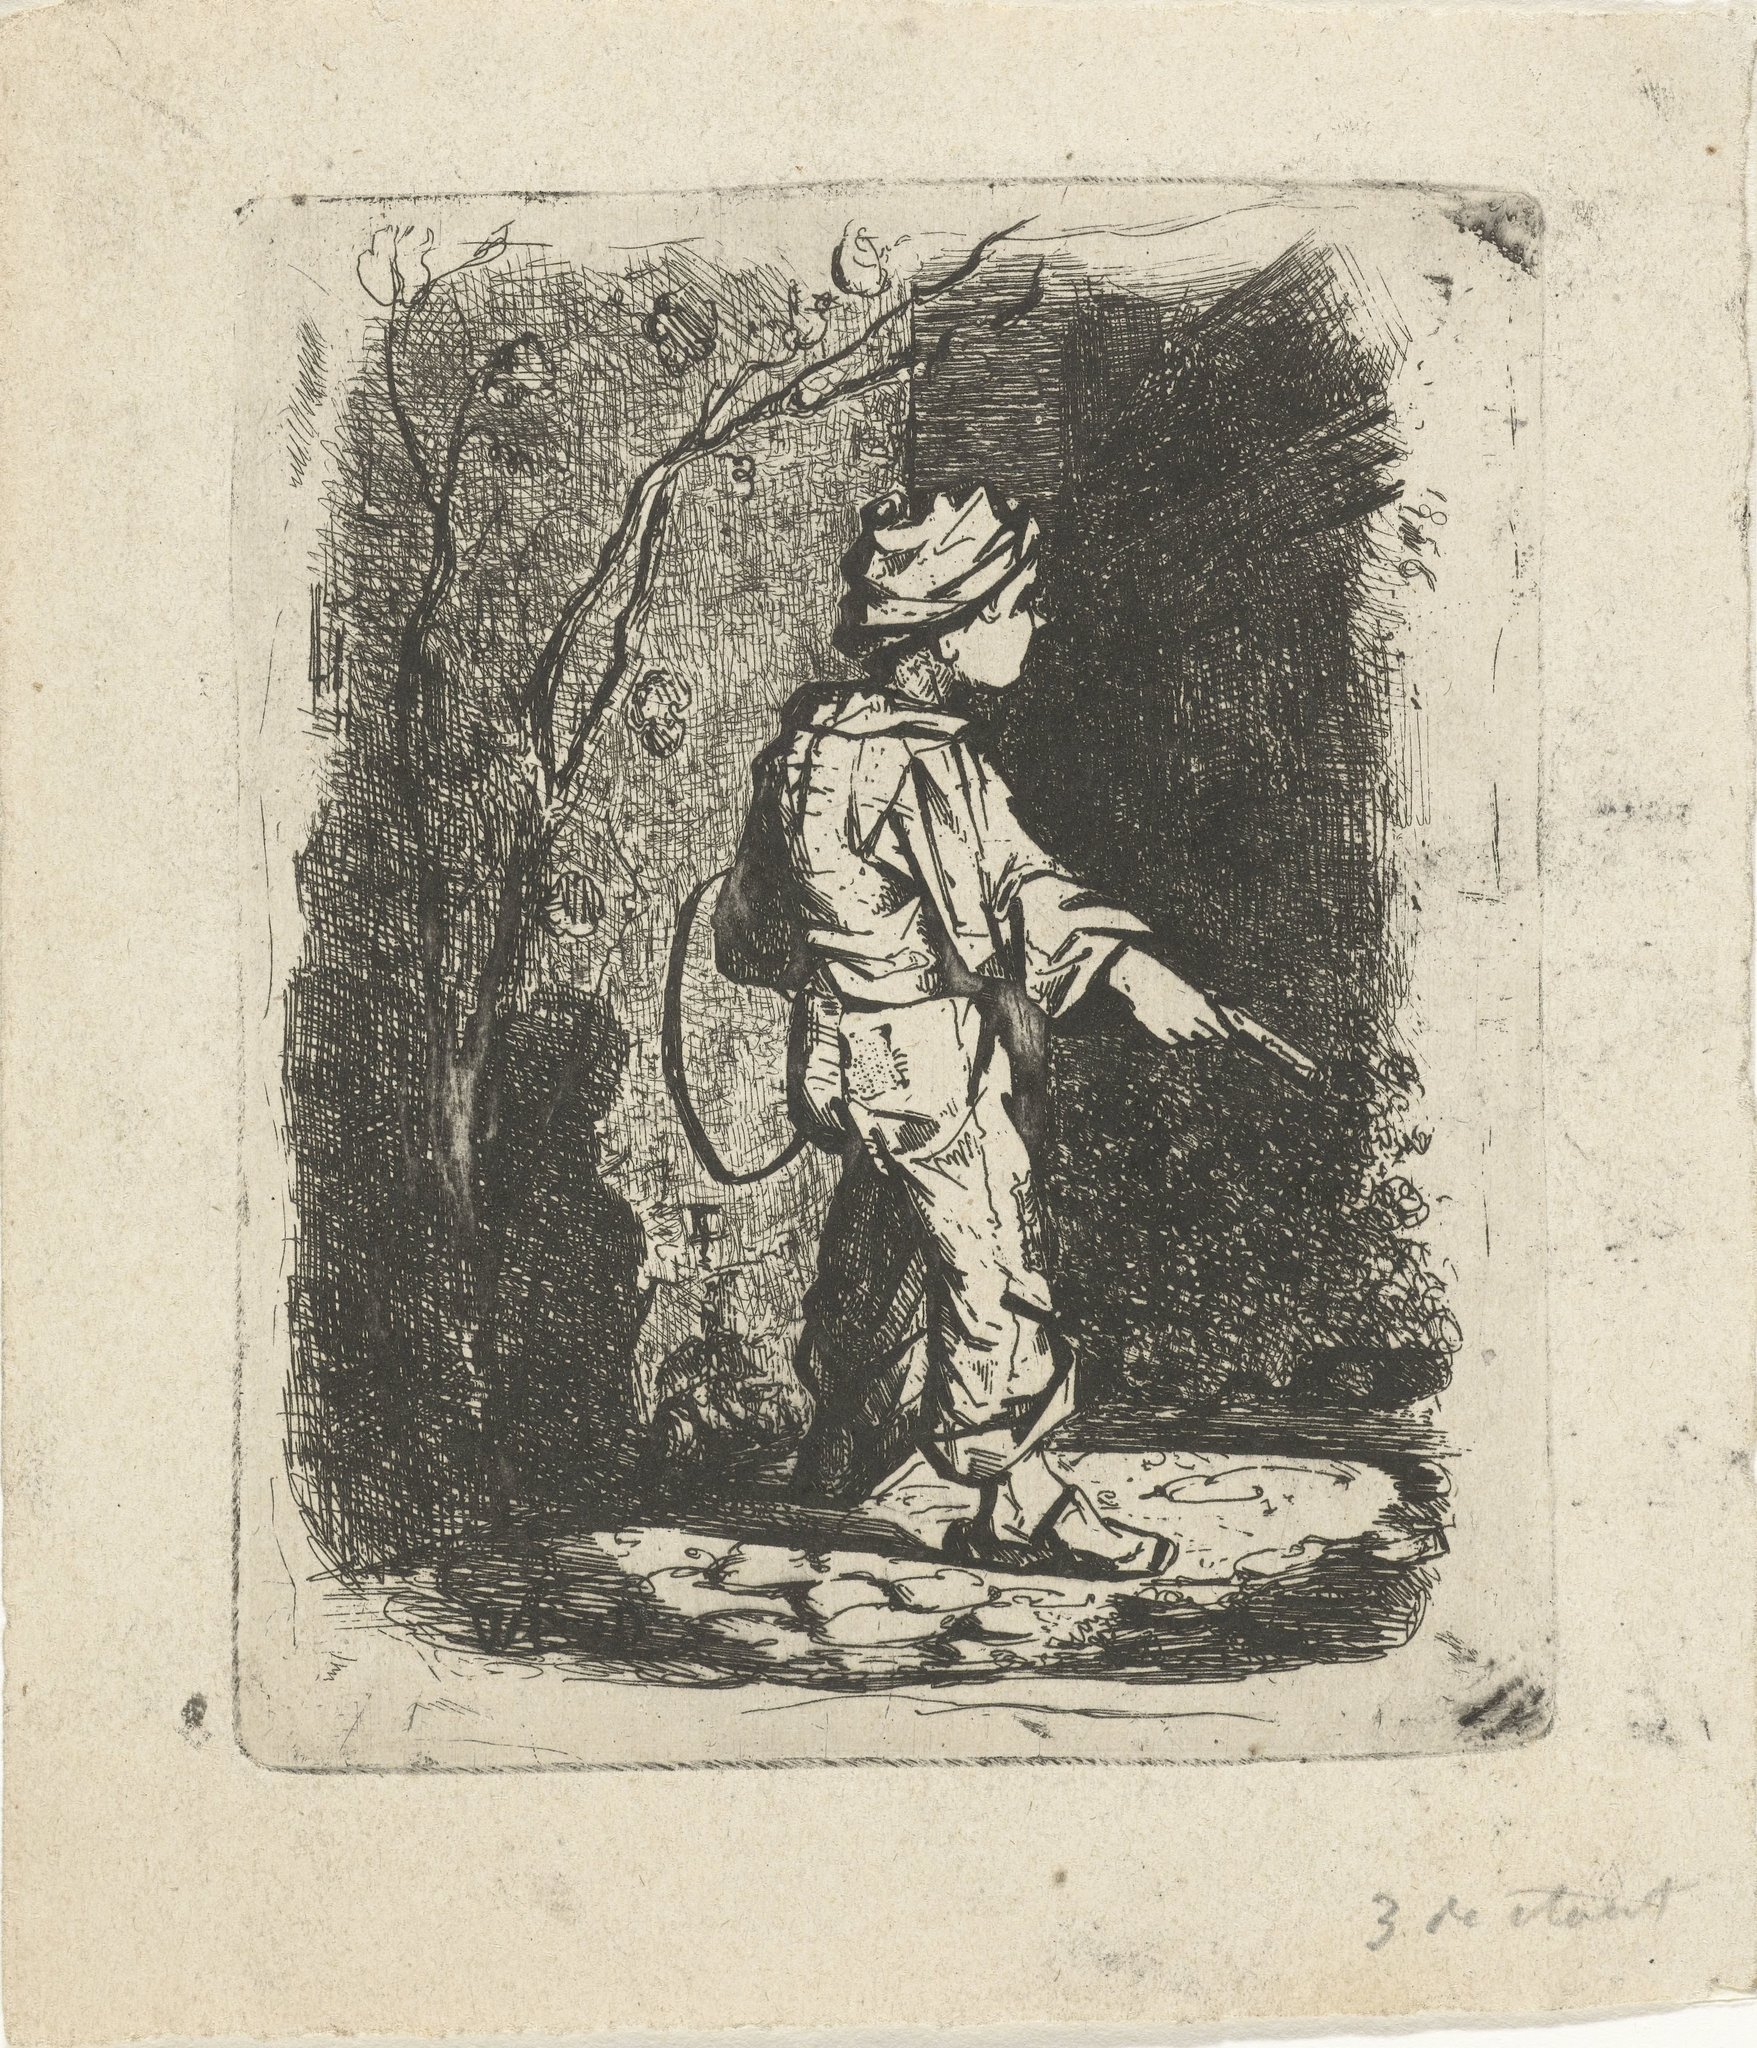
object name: print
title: Jongetje met hoepel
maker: willem cornelis van dijk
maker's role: painter, print maker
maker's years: 1826-1881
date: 1856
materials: paper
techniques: etching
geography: utrecht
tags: (bowling a) hoop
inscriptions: collector's mark: Lugt 2228